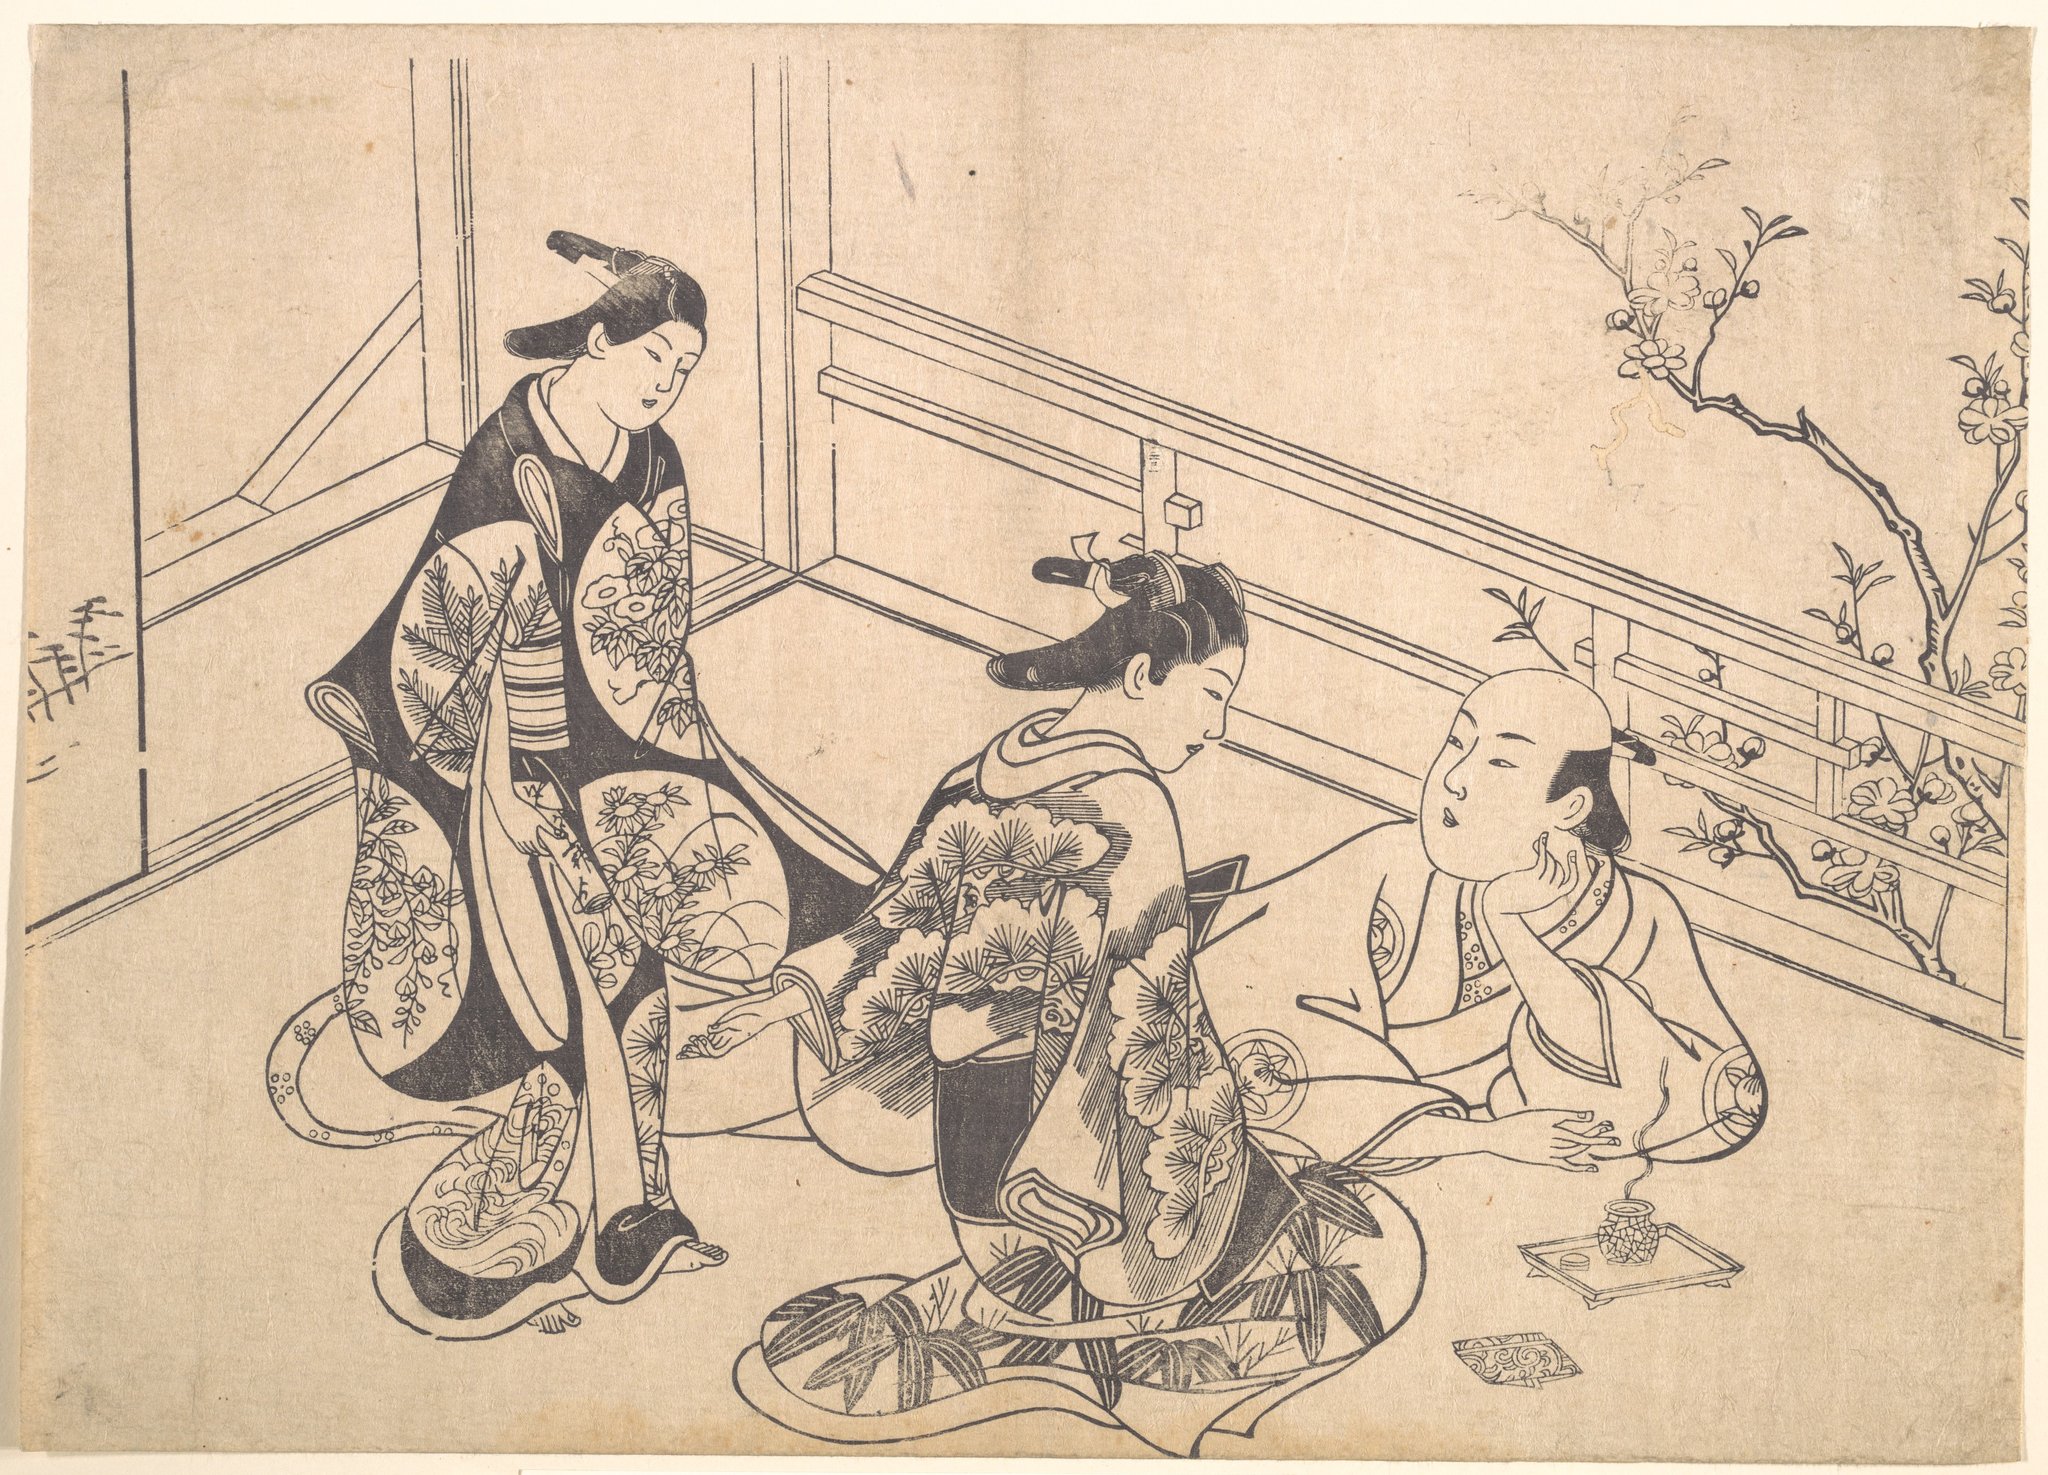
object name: print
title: The Actor Ichimura Takenojo Reclining on a Balcony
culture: japanese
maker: okumura masanobu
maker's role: artist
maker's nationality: japanese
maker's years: 1686-1764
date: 1715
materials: ink, paper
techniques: woodblock print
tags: men,women,actors